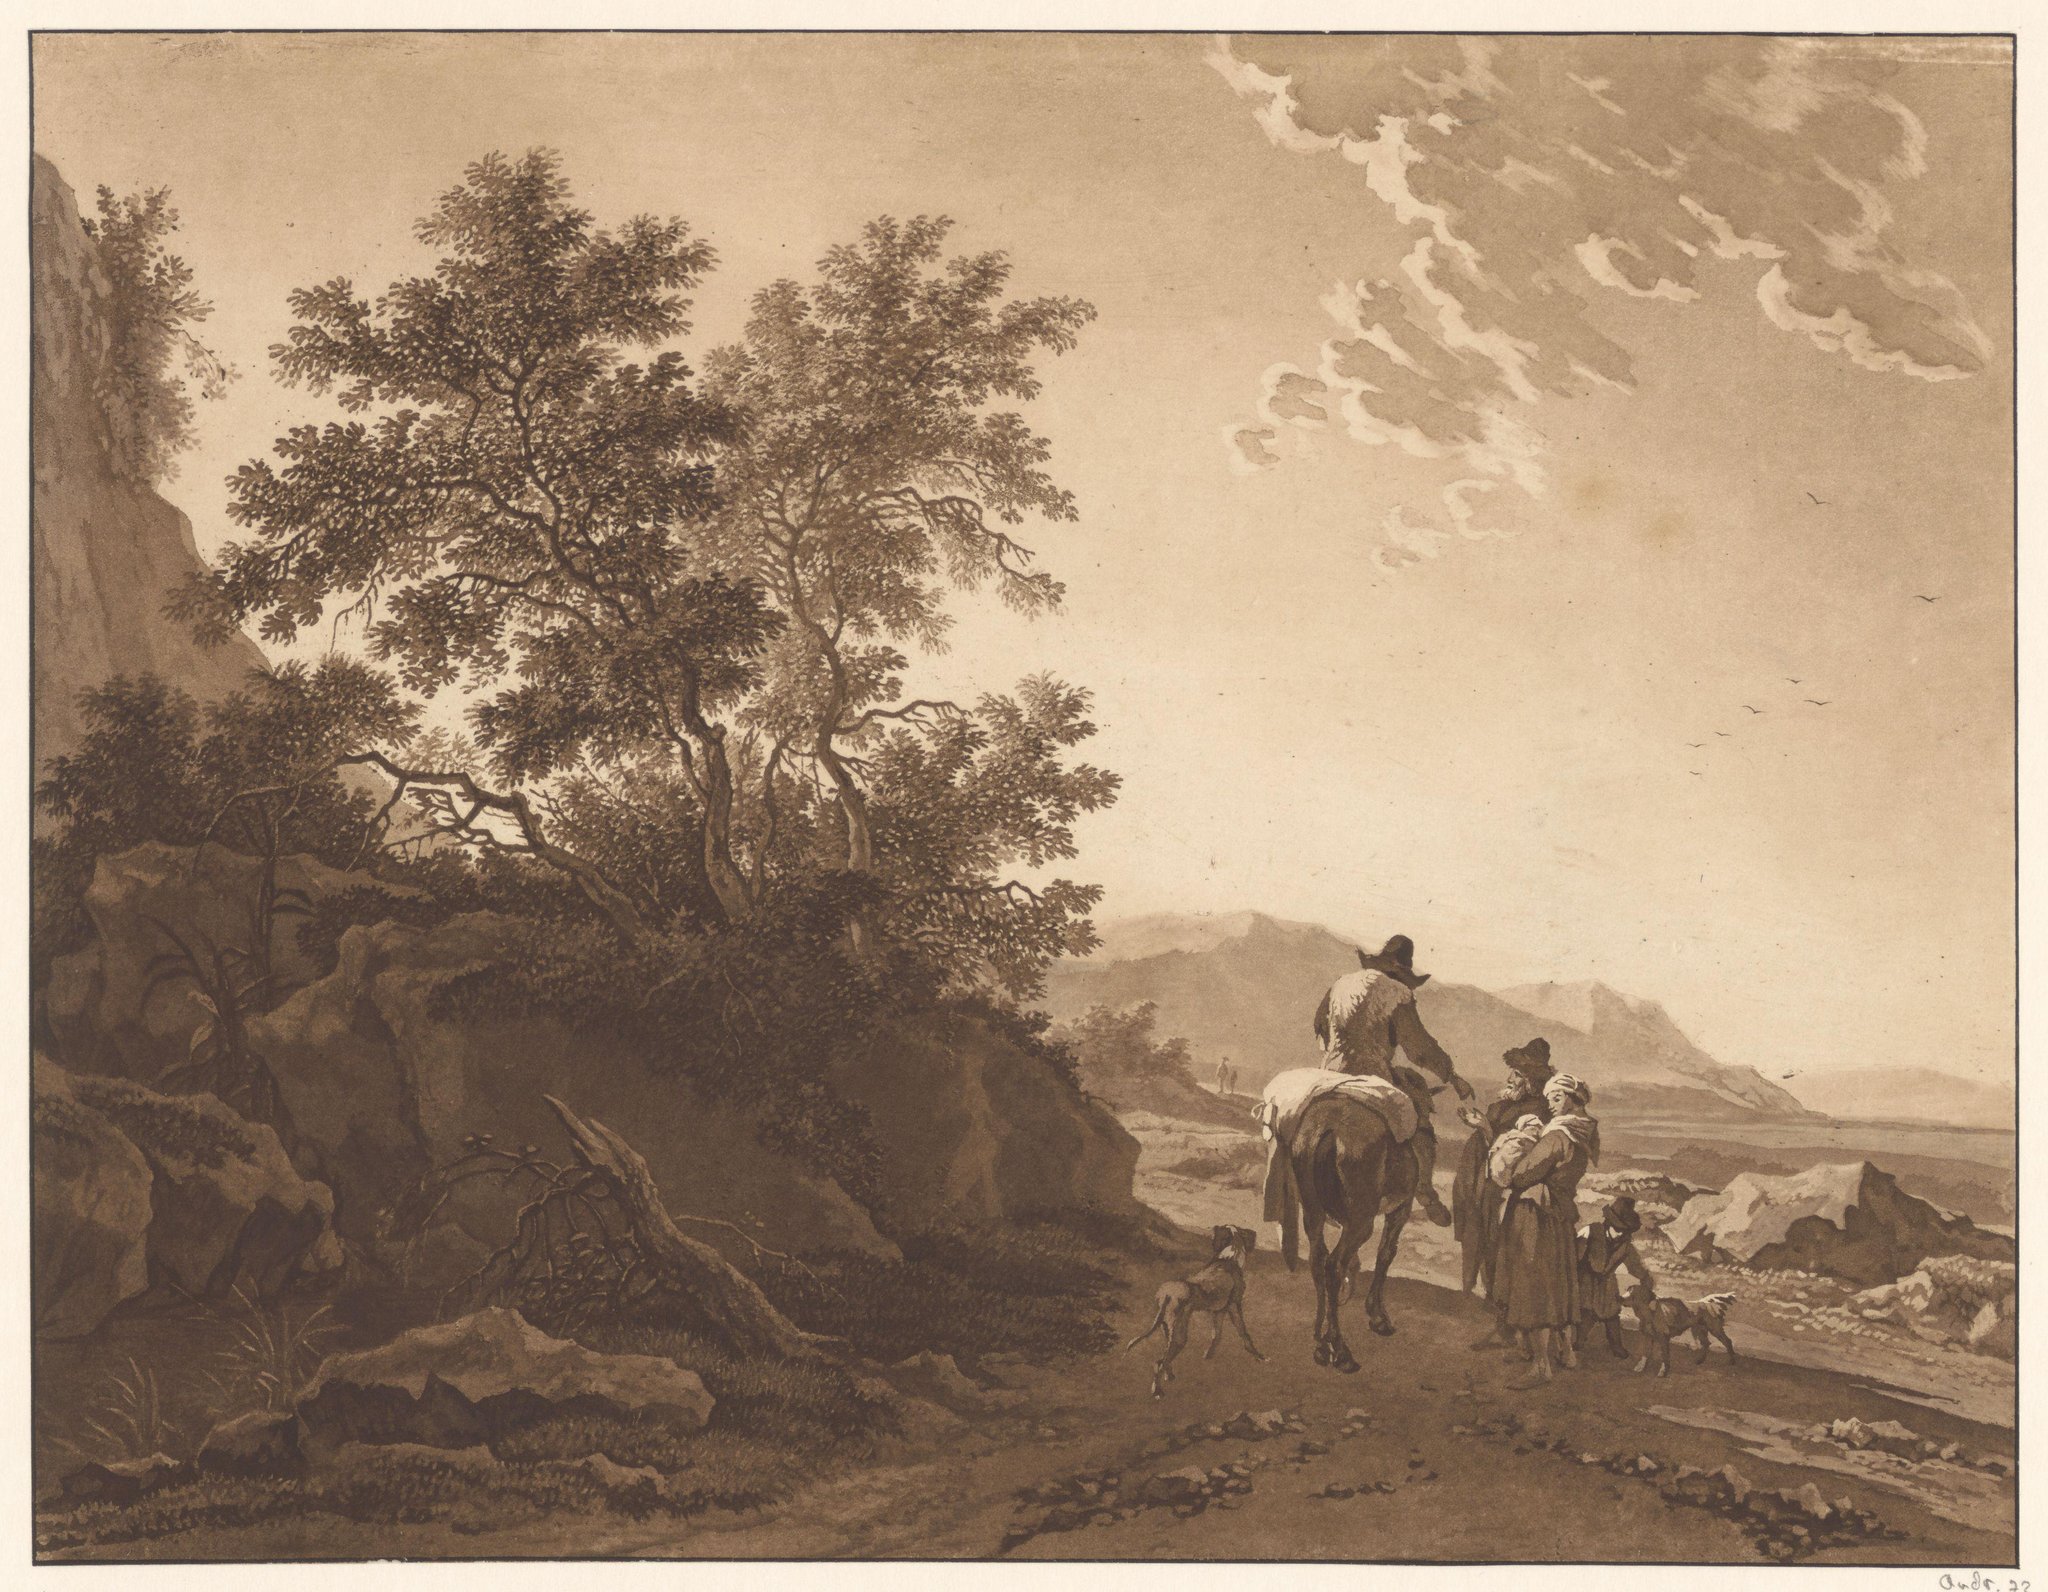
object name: print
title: Landschap met ruiter die een aalmoes geeft aan een man met familie op een pad langs de kust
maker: wilhelm alexander wolfgang von kobell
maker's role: print maker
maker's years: 1766-1855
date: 1791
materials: paper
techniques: aquatint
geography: mannheim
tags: giving alms or other charity, e.g.: handing out food, rocky coast, 'fahrende leute', vagrants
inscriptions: collector's mark: Lugt 2228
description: De strook tekst op het verso van de prent suggereert dat deze gemaakt is naar een schilderij door Nicolaes Pietersz. Berchem uit de collectie van de La Galerie Electorale te München.